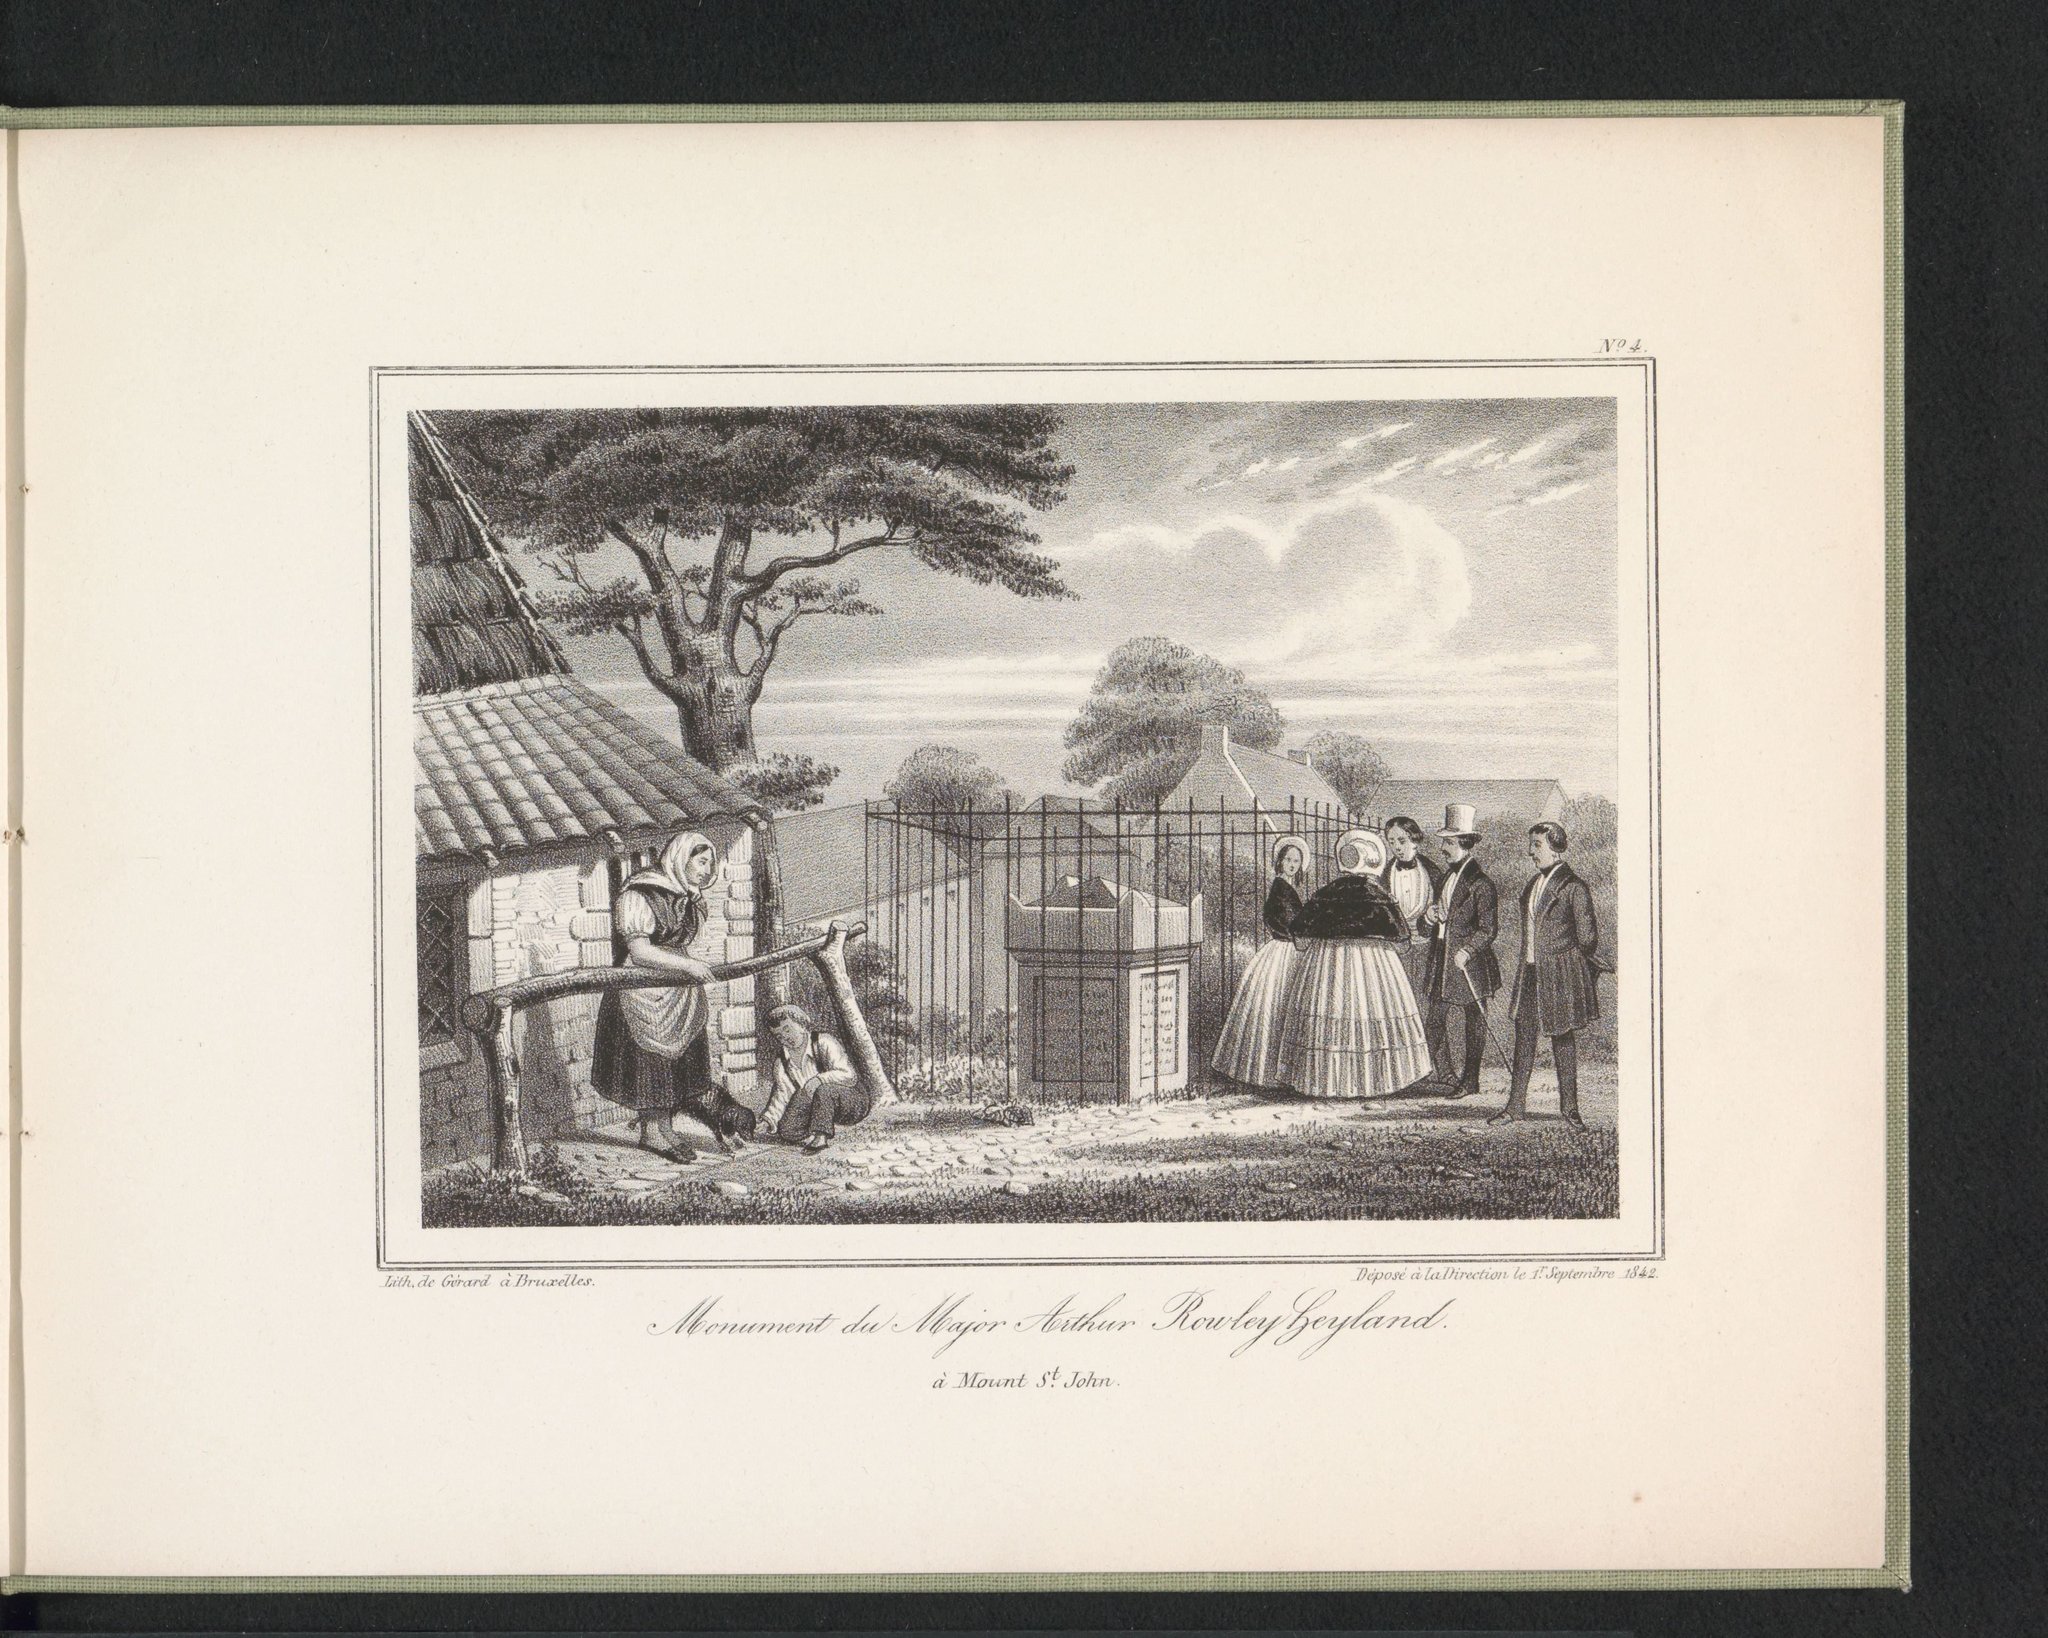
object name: print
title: Graf van Arthur Rowley Heyland in Mont-Saint-Jean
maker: h. gérard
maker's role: printer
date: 1842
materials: paper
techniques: lithograph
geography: brussels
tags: grave, tomb, waterloo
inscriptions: date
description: Gezicht op het graf van de Britse militair Arthur Rowley Heyland in Mont-Saint-Jean bij Waterloo. Bij het omheinde graf staan vijf bezoekers. Rowley Heyland sneuvelde tijds de slag. Onderdeel van een album met twaalf platen met gezichten uit ca. 1840-1846 van de omgeving waar de slag bij Waterloo plaatsvond op 18 juni 1815. Genummerd rechtsboven: No. 4.